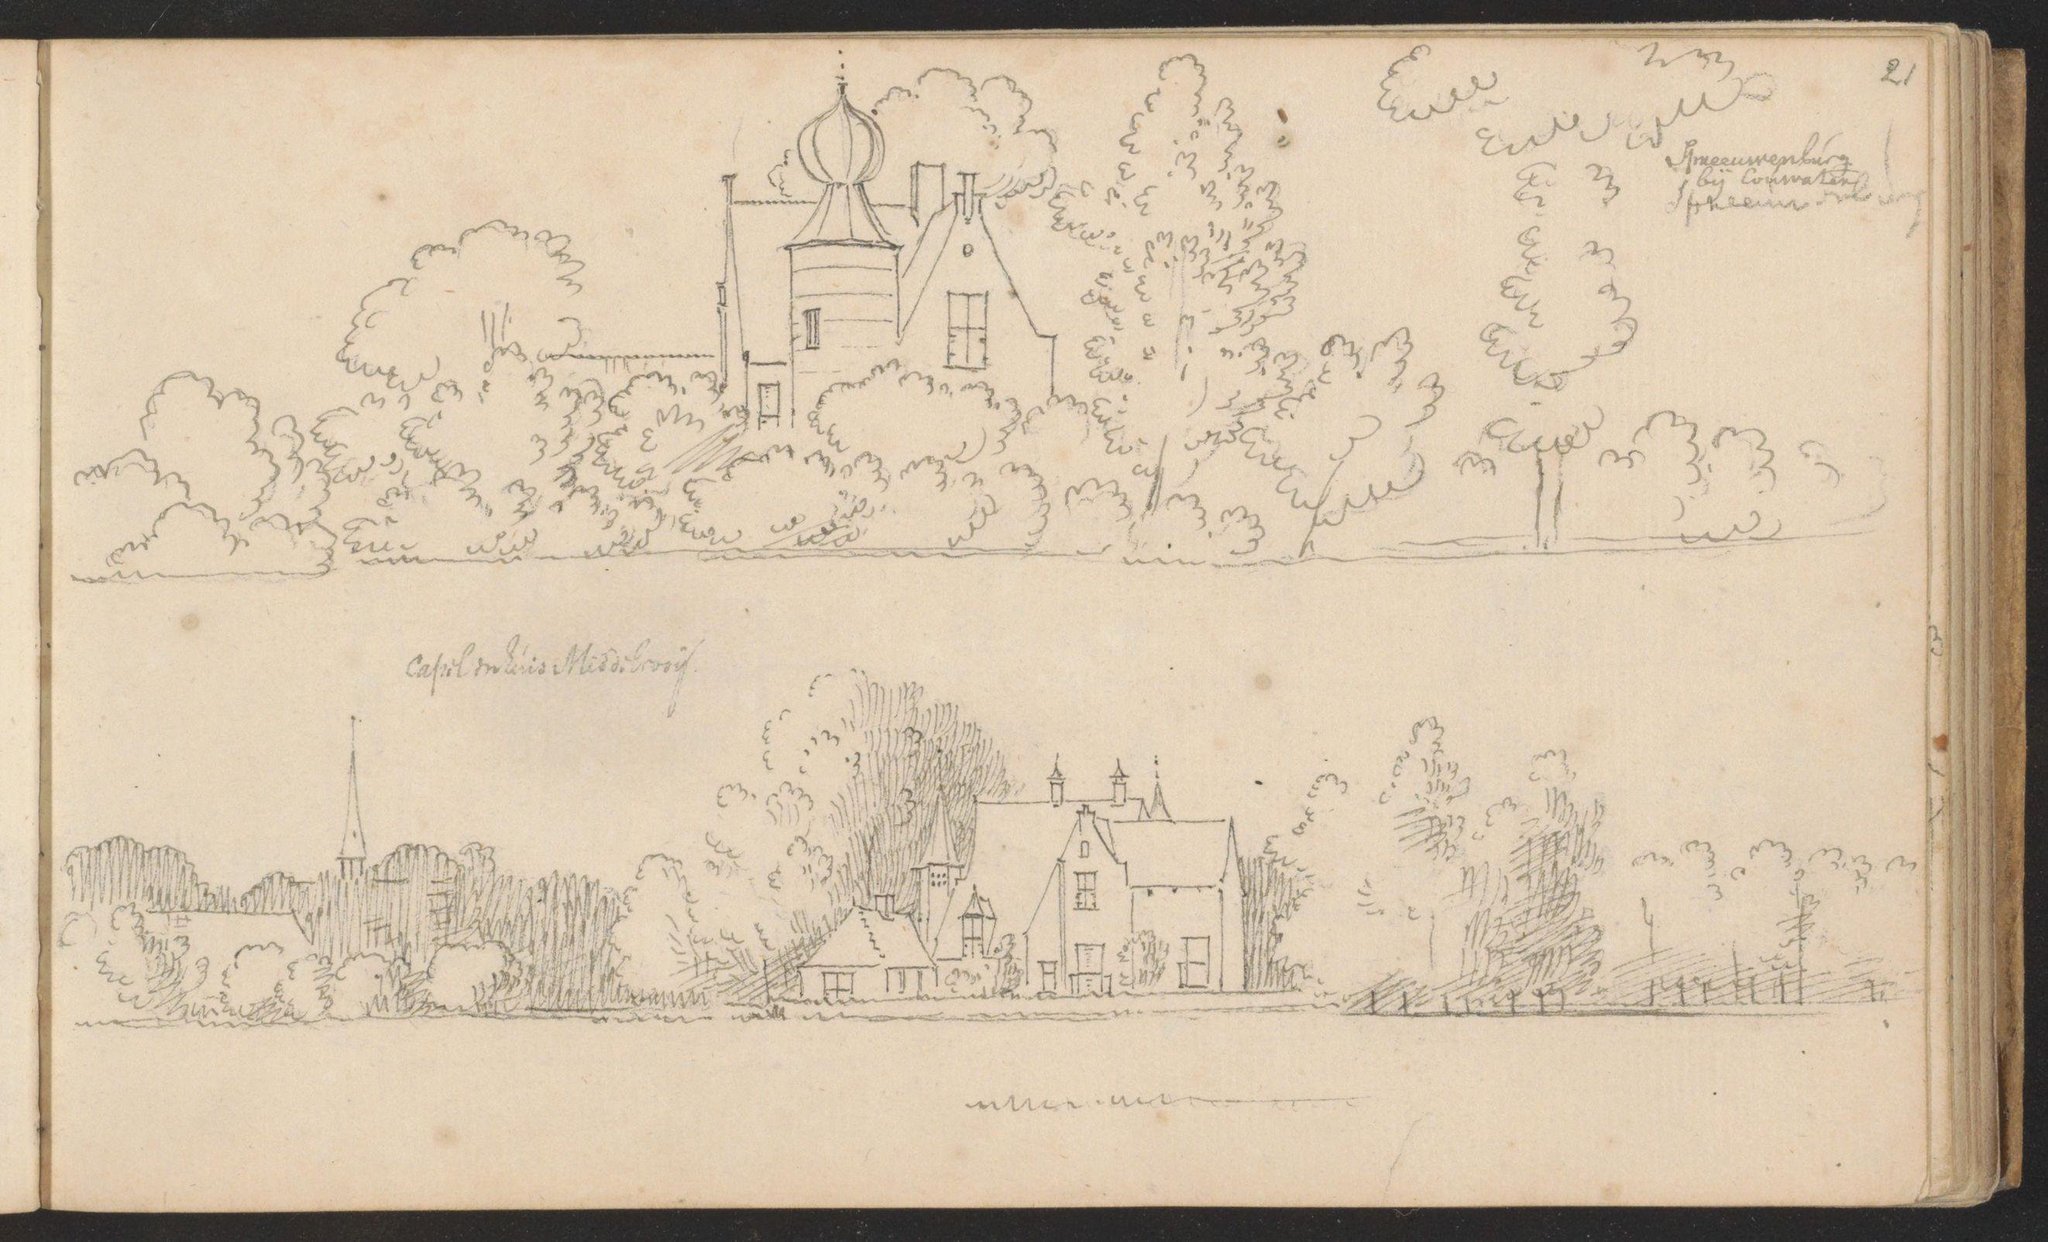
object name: sketchbook leaf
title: Kasteel Spreeuwenburg bij Coudewater en gezicht te Middelrode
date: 1701-1759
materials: ink, paper, pencil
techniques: pen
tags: castle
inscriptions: annotation: ‘Spreeuwenburg/ bij Couwater/ capel en huis? middelrooij’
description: Blad 21 recto uit een schetsboek met 65 bladen.